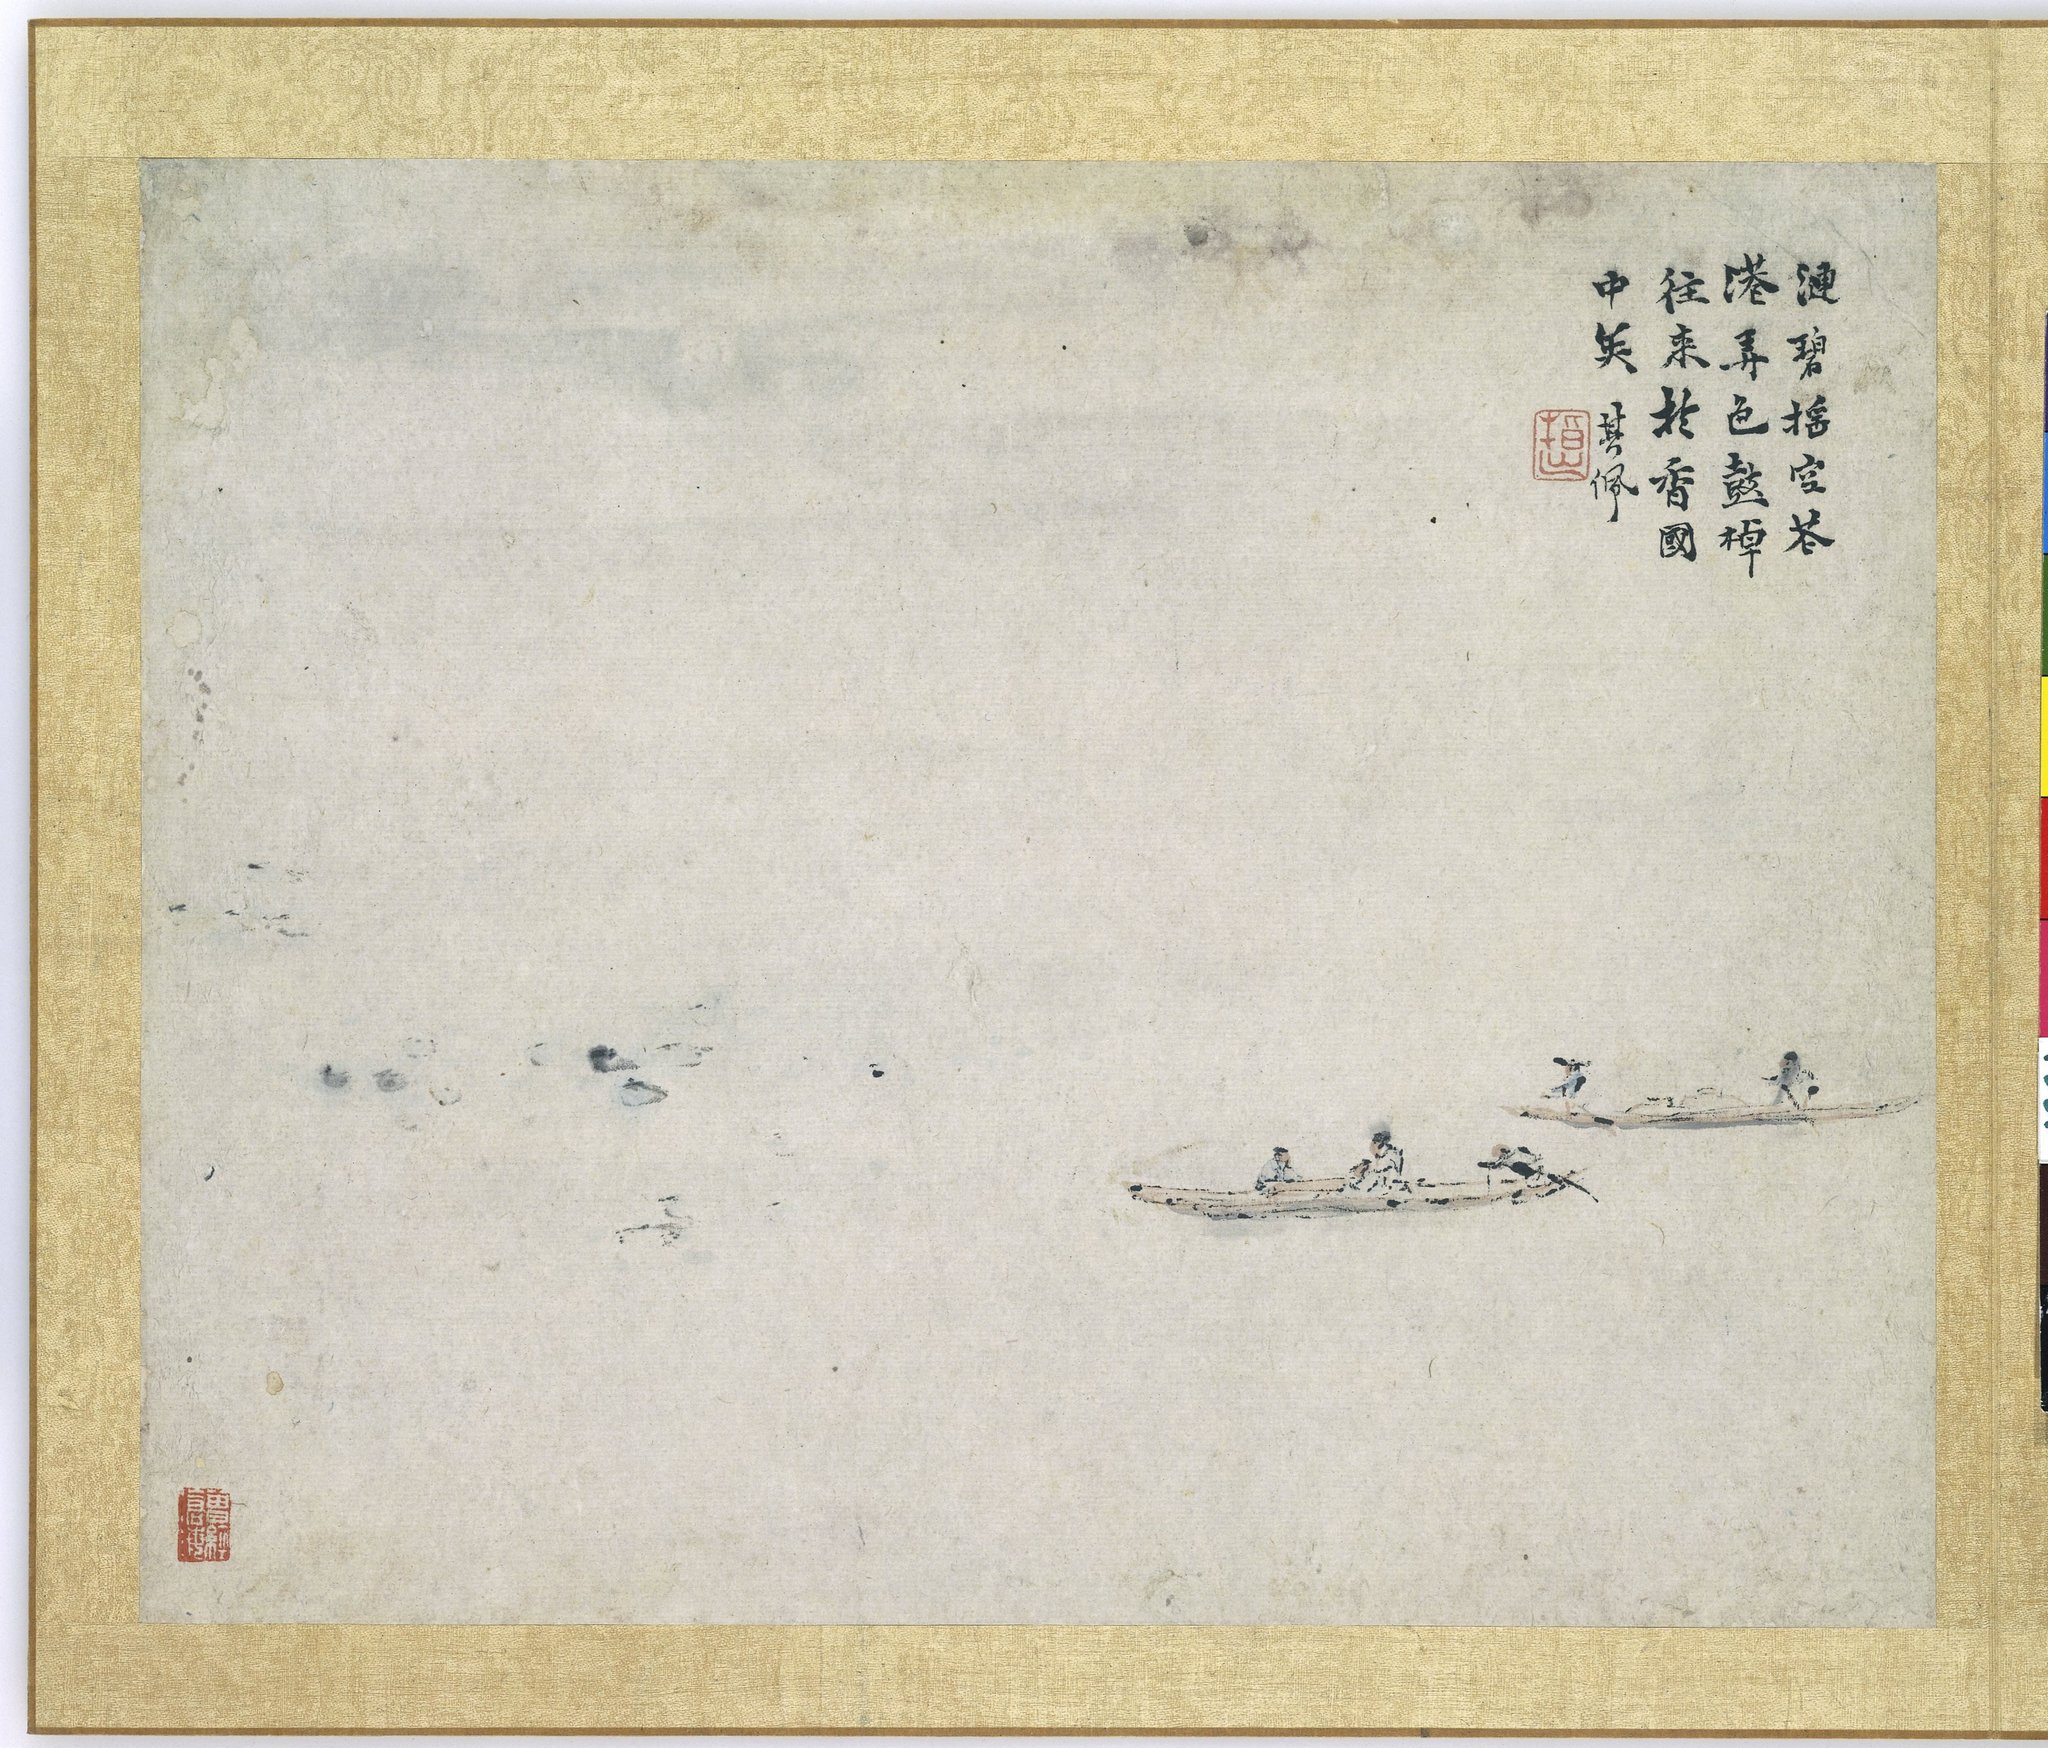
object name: finger painting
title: Schildering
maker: gao qipei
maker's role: painter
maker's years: 1661-1734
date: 1700-1750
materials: dye, ink, paper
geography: china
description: Two rowing boats on the water. Gao Qipei (1660 - 1734). China, c. 1700. Colours and ink on paper. The finger painter Gao Qipei experimented with techniques of painting. 'One should allow the hand to do the painting', he remarked. He was fascinated by the unpredictability of the line produced by the finger or the nail. The inscription on the right reads:'The sky is cradled in the azure waves, the flower harbour is patterned with colour, the oars swish to and fro in the realm of perfumes. Qipei'